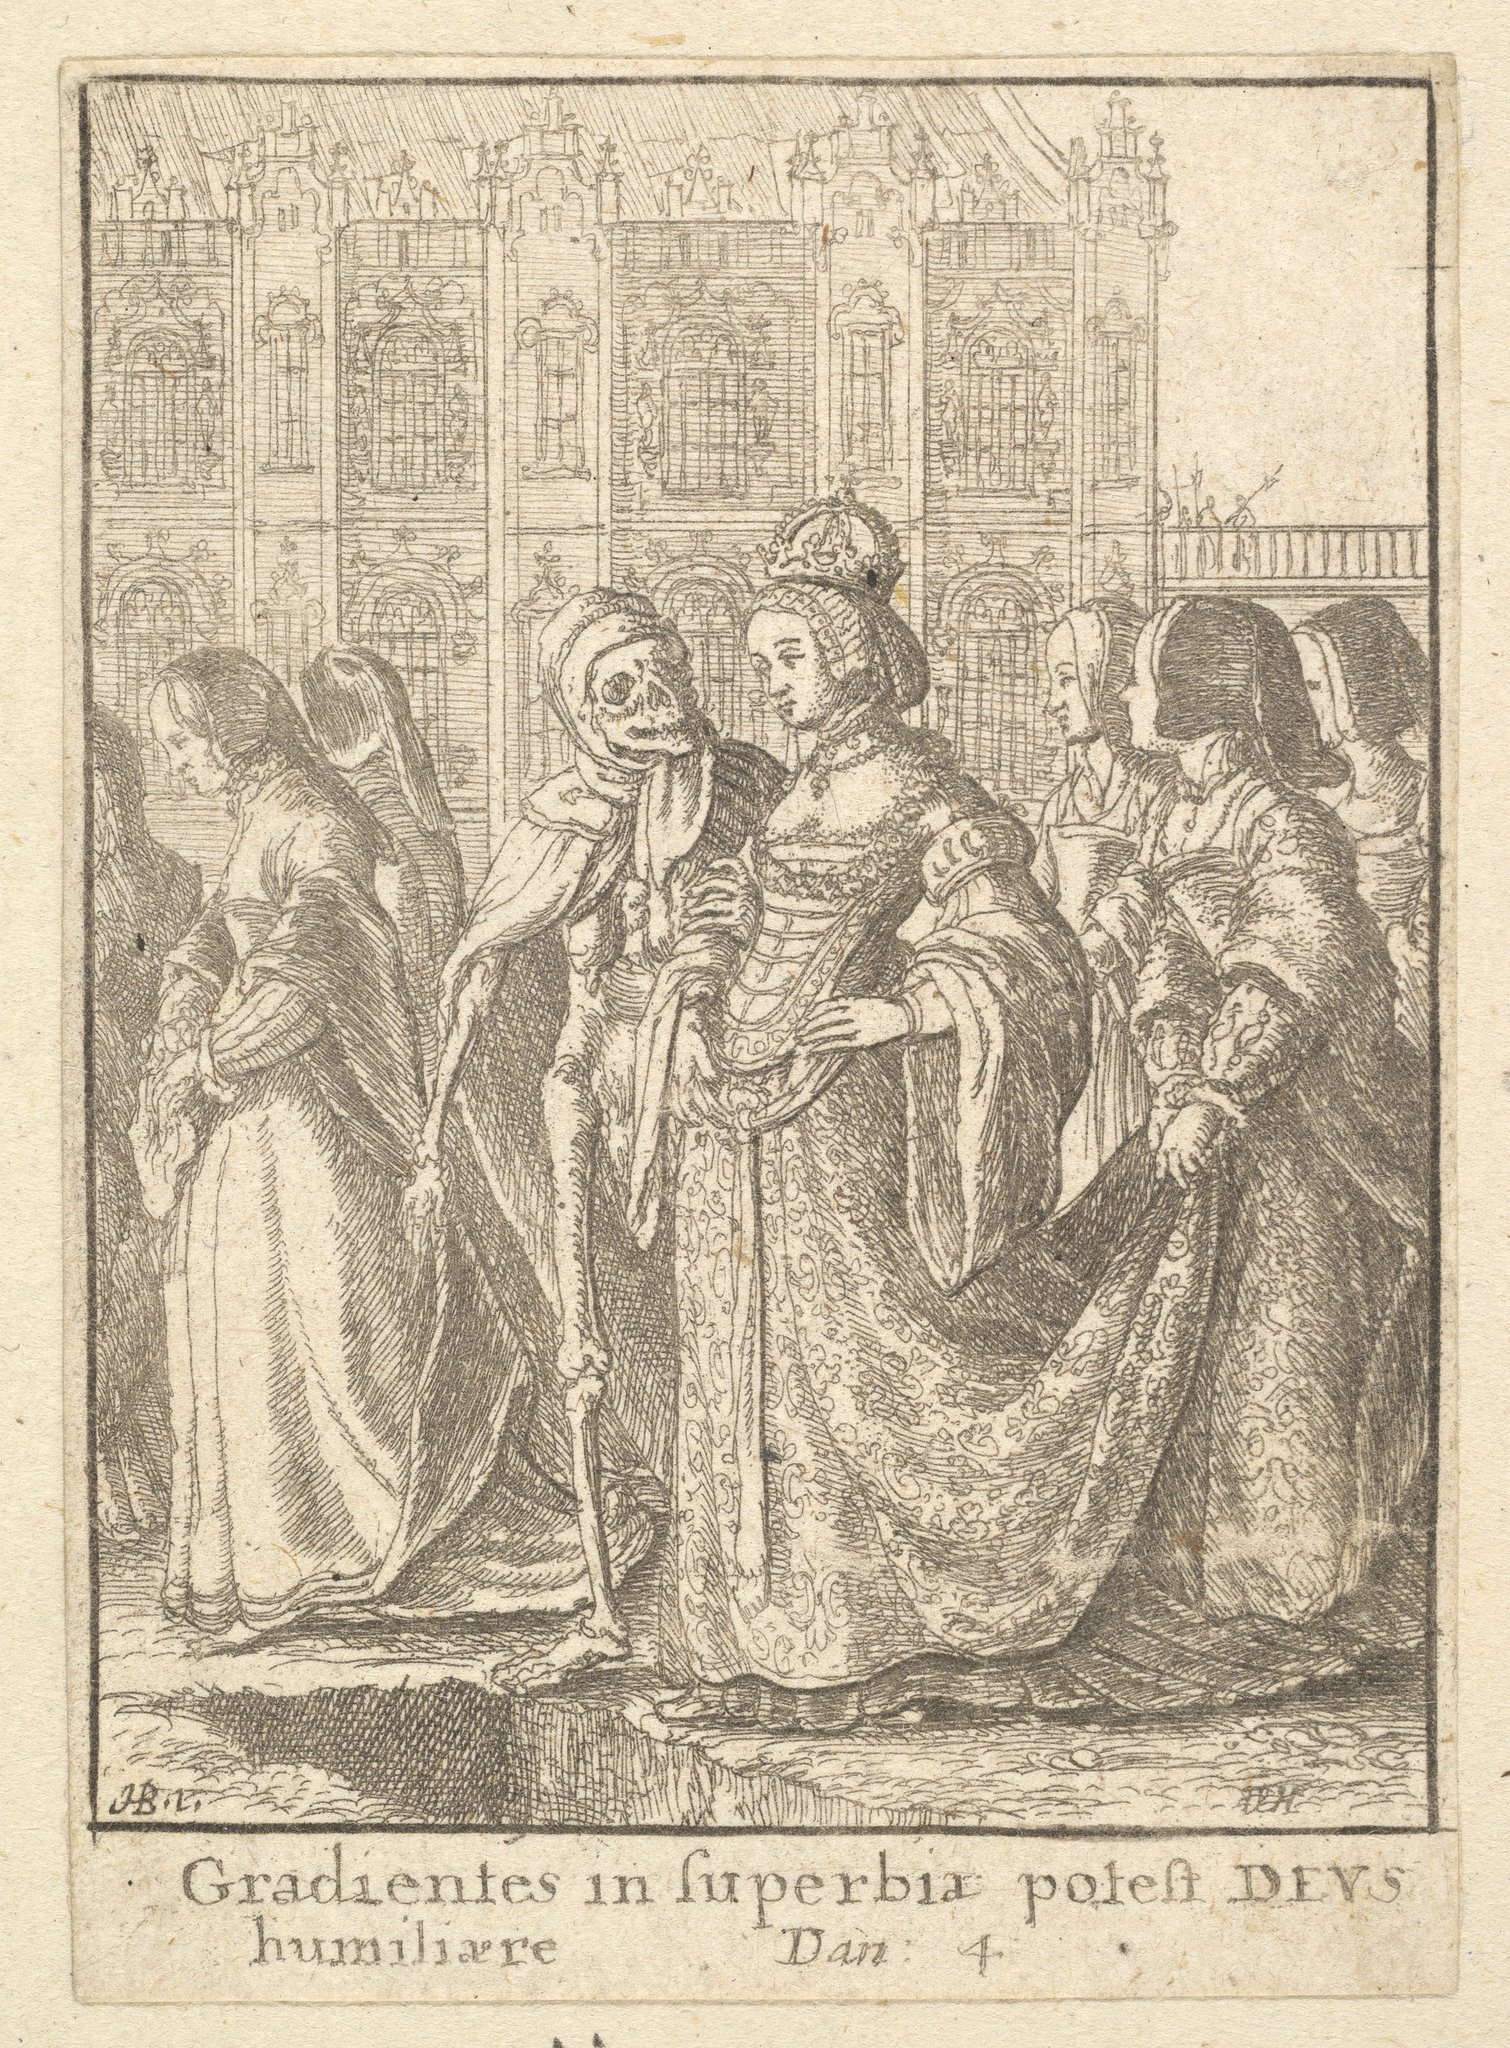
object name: print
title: Empress, from the Dance of Death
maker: wenceslaus hollar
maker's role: artist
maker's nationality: bohemian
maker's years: 1607-1677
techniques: etching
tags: skeletons,women